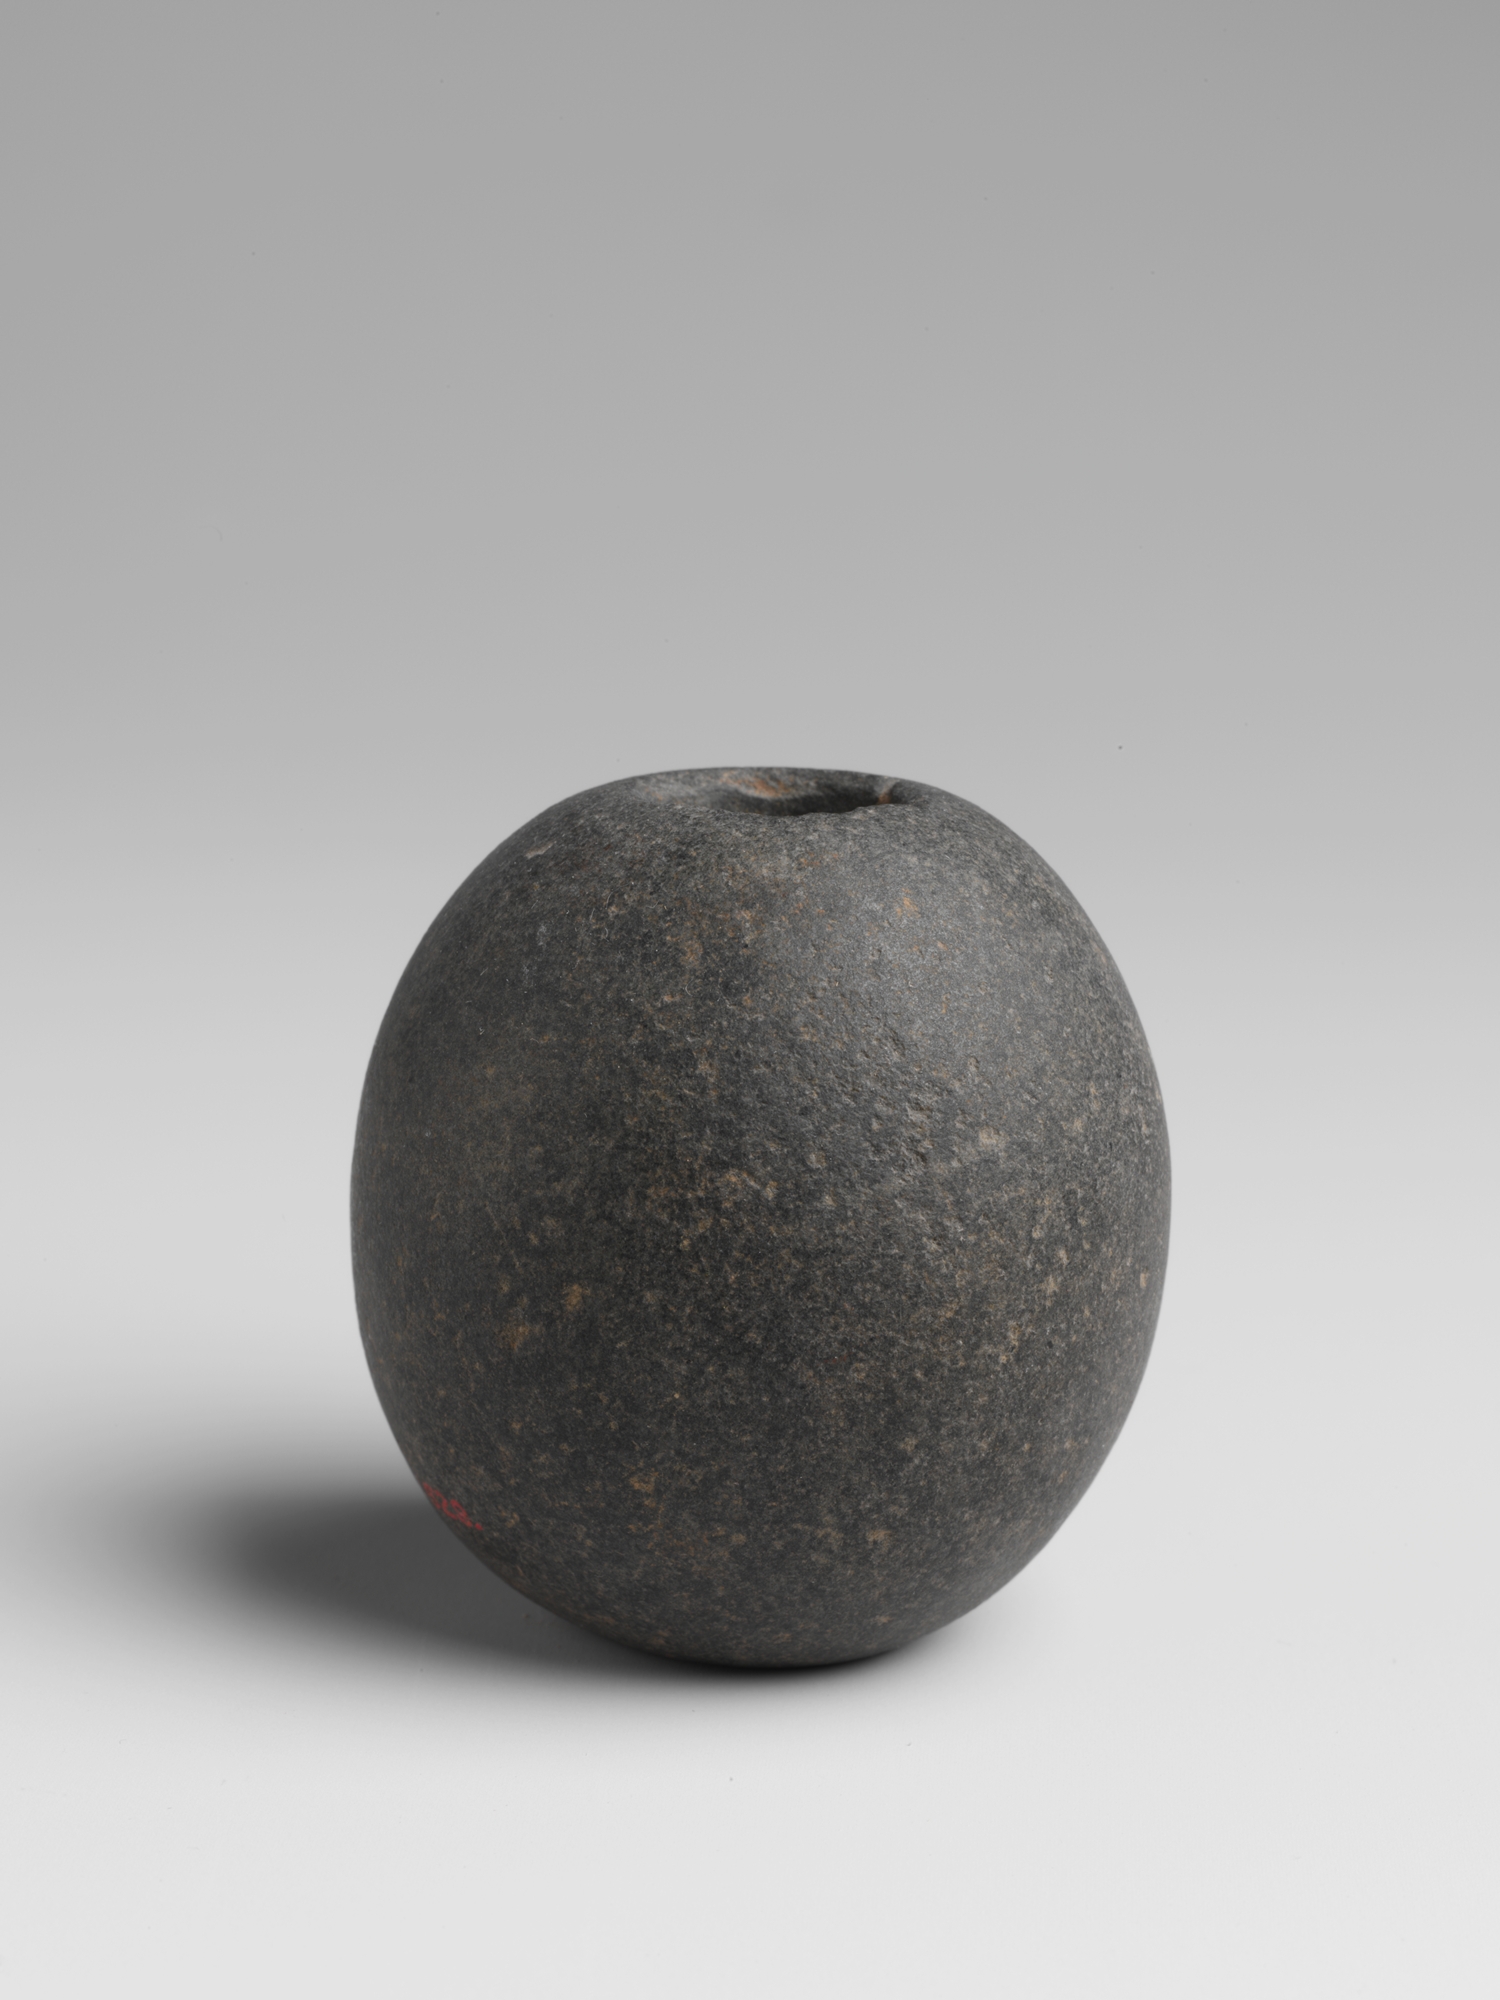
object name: mace head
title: Gabbro mace head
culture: cypriot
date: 2500-1900 BCE